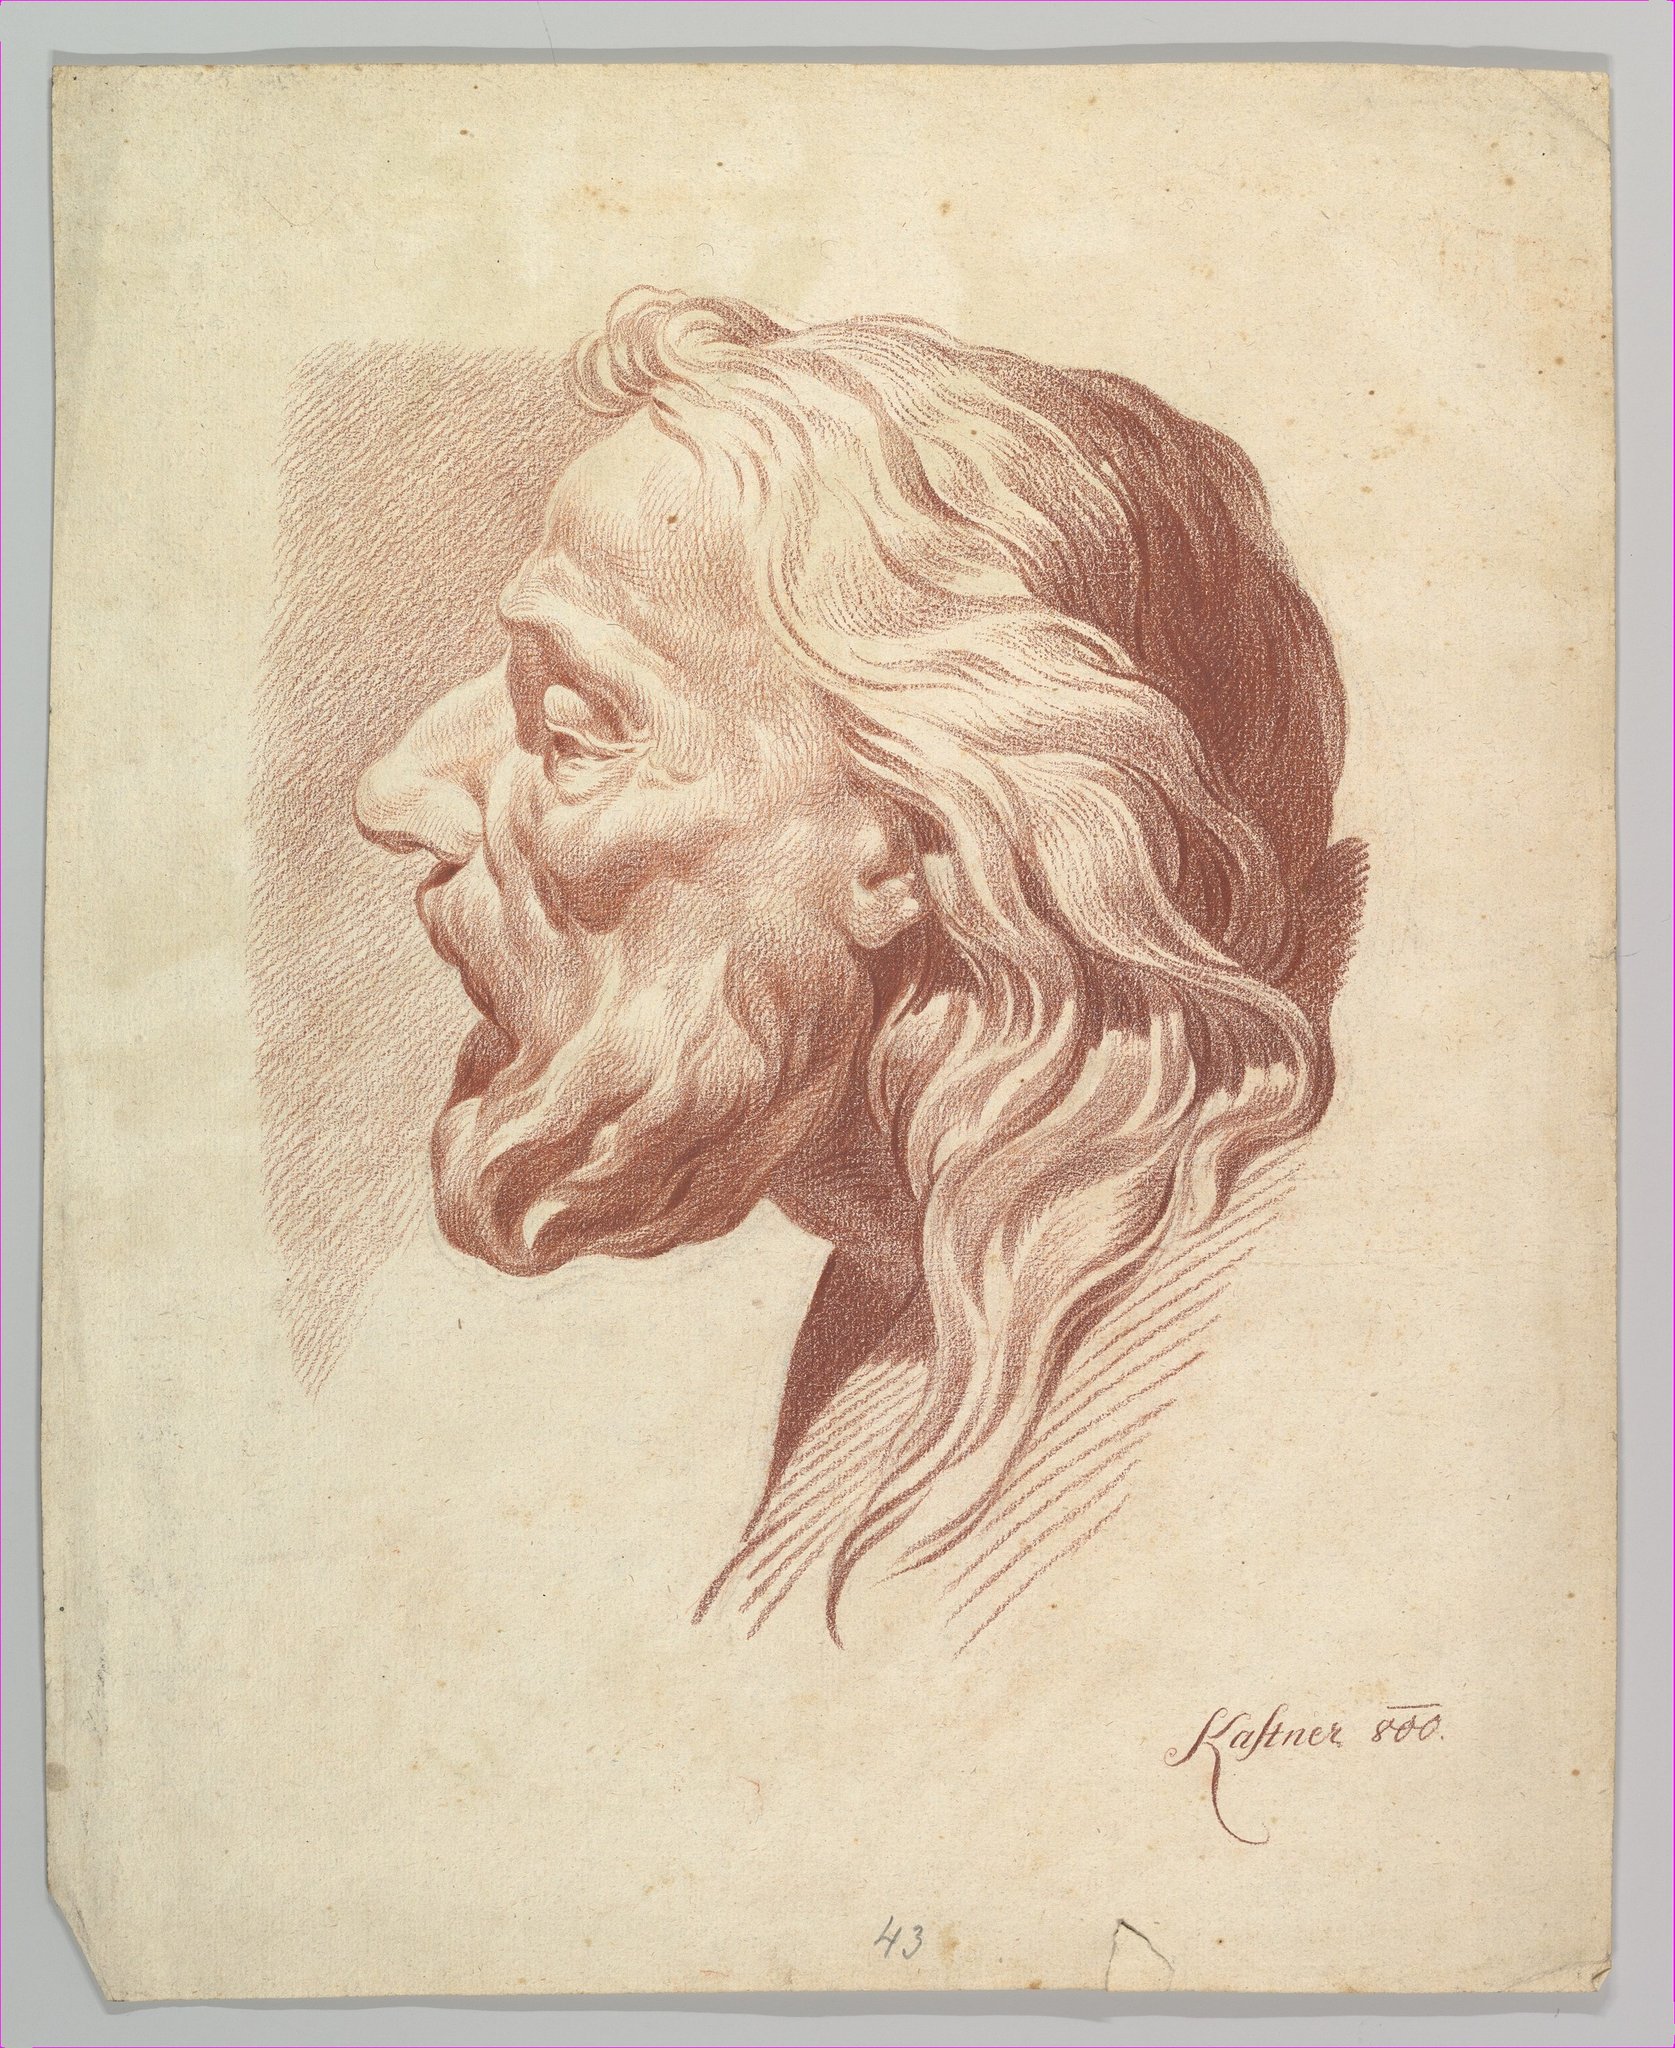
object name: drawing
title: Head of a Bearded Old Man in Profile to the Right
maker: johann evangelist kastner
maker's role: artist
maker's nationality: austrian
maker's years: 1776-1827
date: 1800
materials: chalk, graphite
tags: men